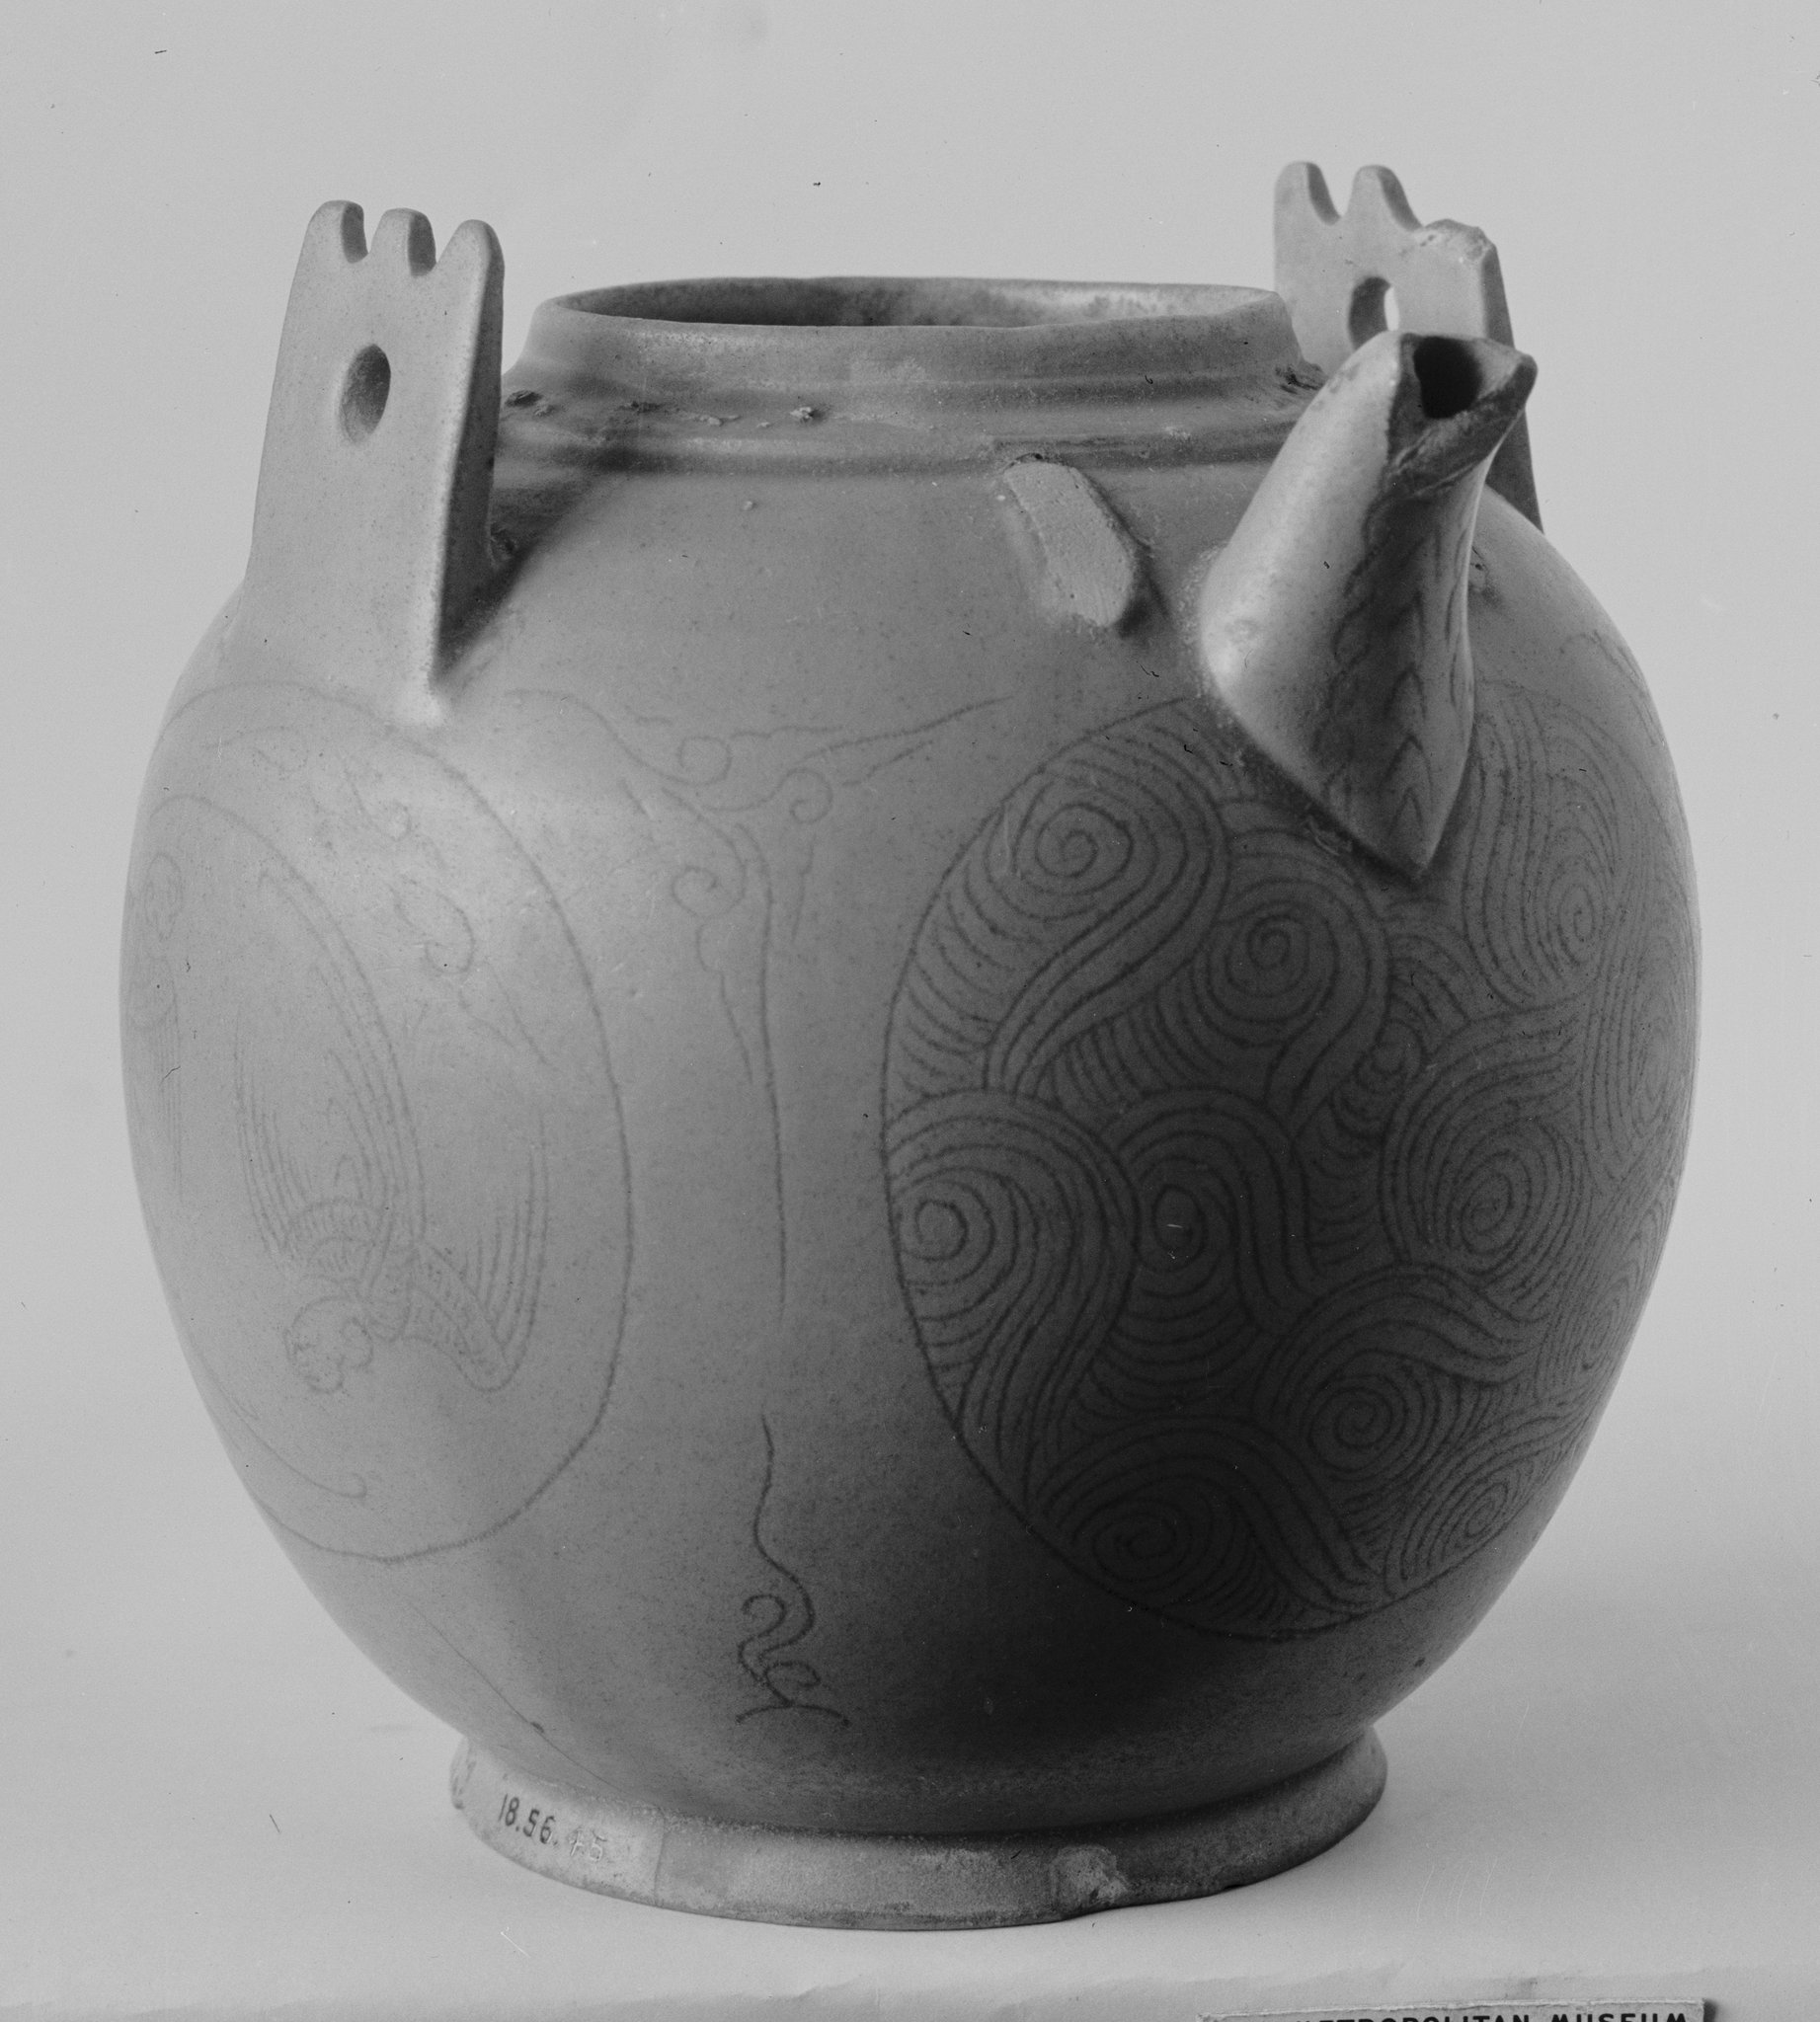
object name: ewer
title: Ewer with lug handles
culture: chinese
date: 801-900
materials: ceramic glaze, glaze, stoneware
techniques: incising